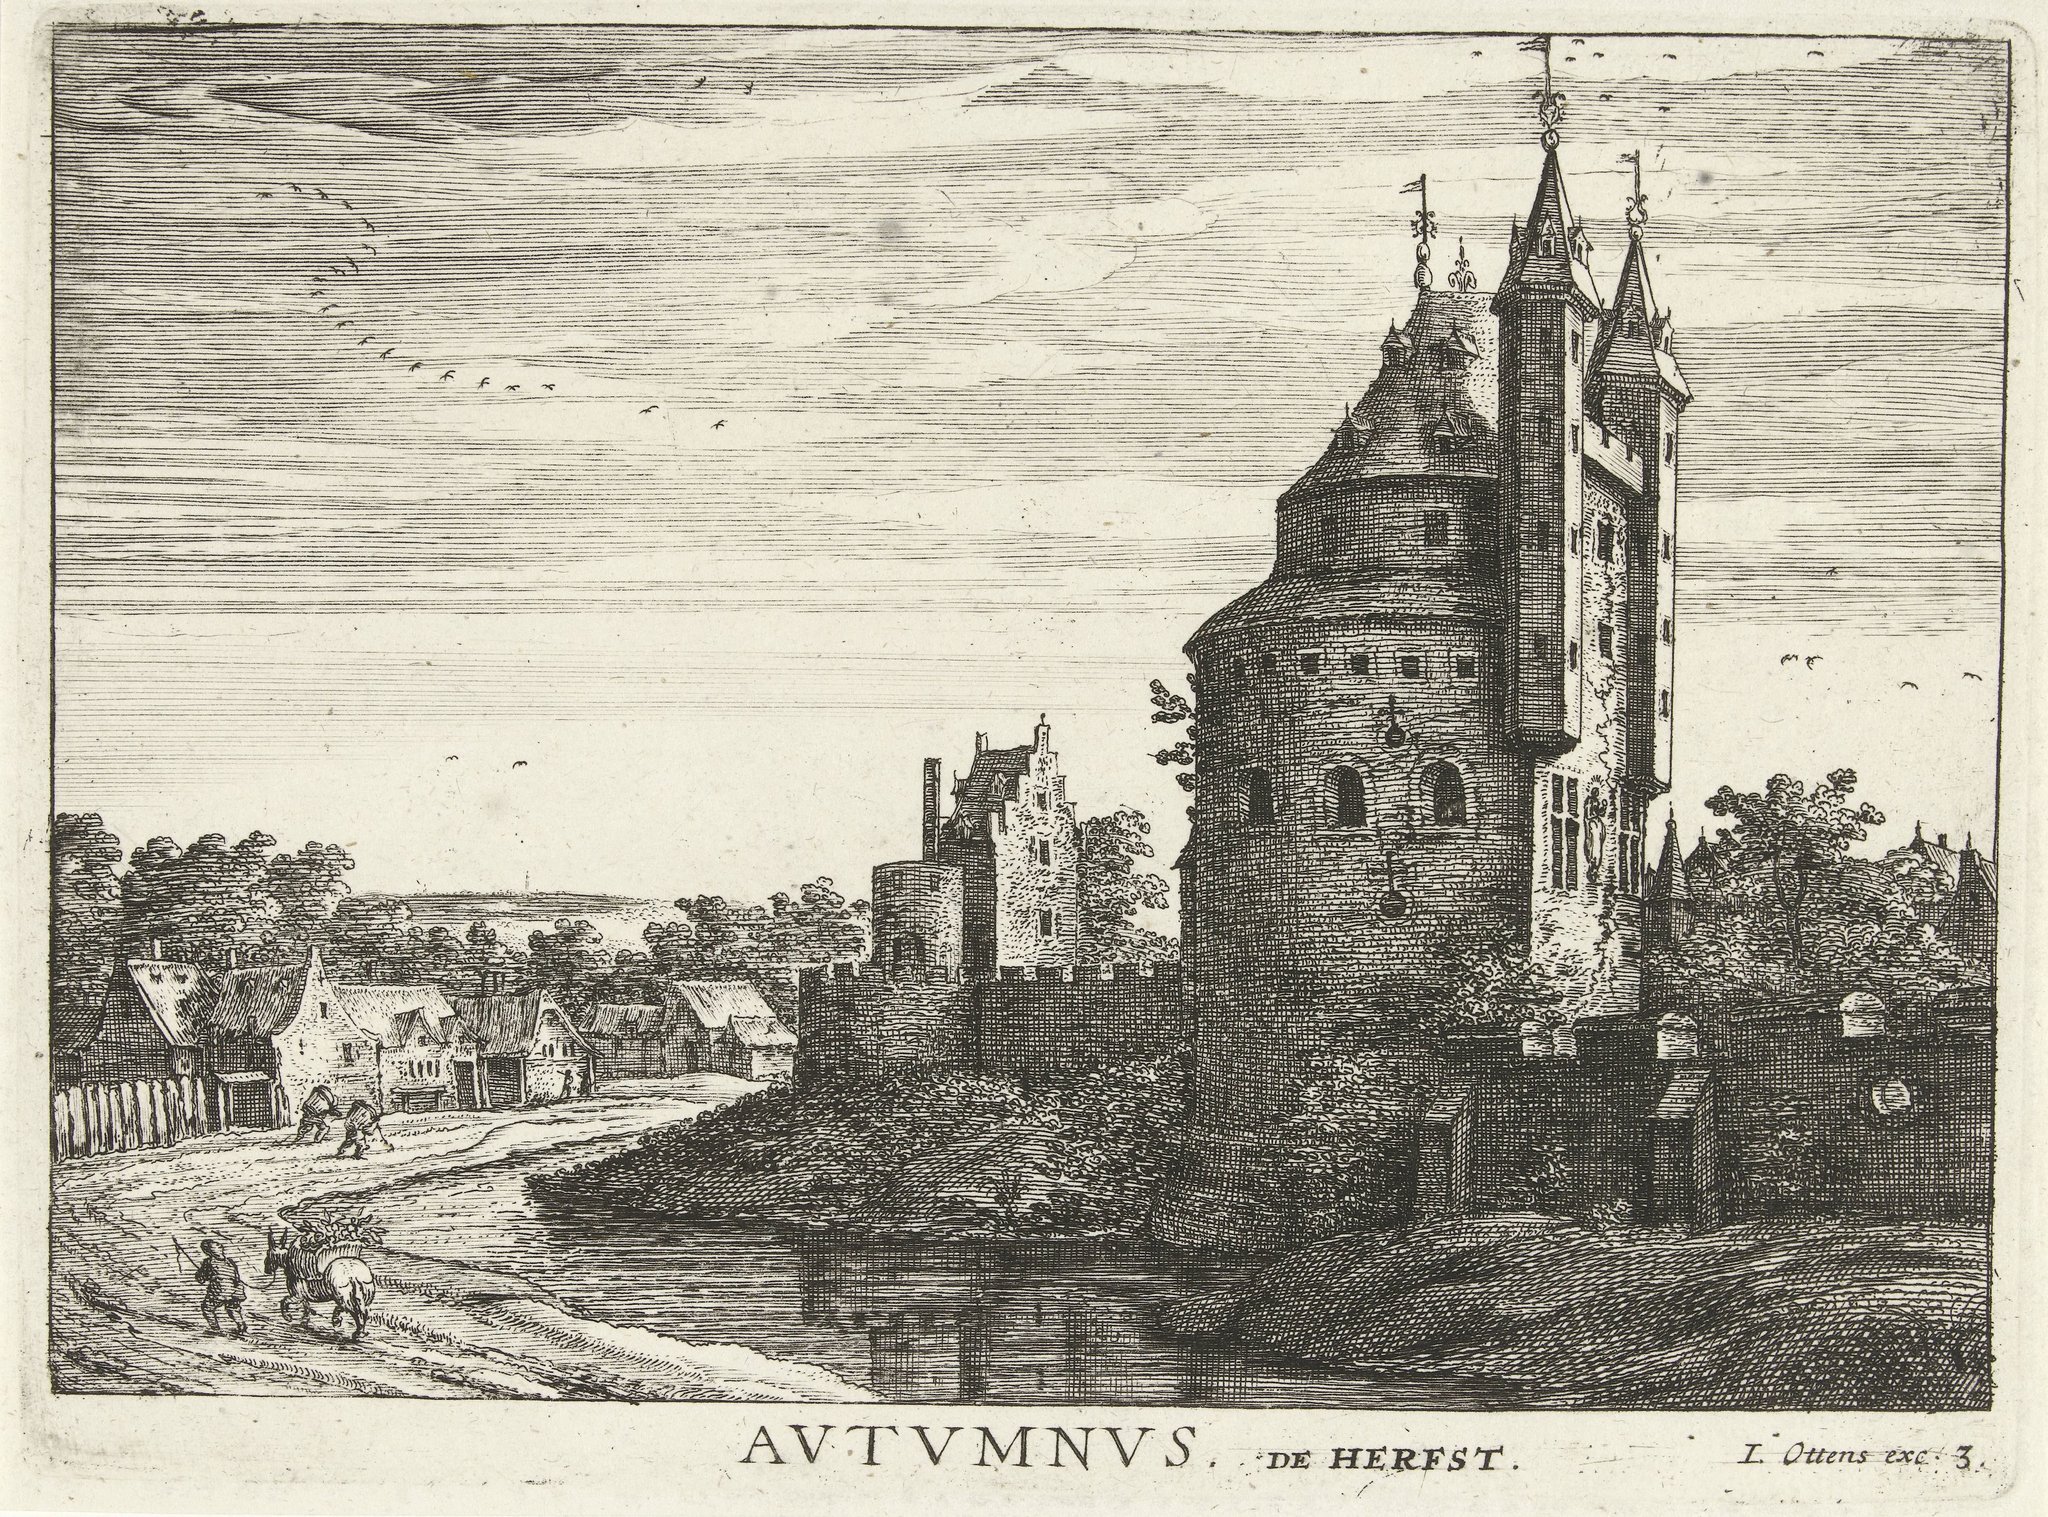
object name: print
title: Herfst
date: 1644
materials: paper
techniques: etching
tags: autumn landscape; landscape symbolizing autumn (the four seasons of the year)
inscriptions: collector's mark: Lugt 2228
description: Landschap met een versterkt huis en een landweg met enkele figuren en pakezel. Prent uit een serie van de vier seizoenen.